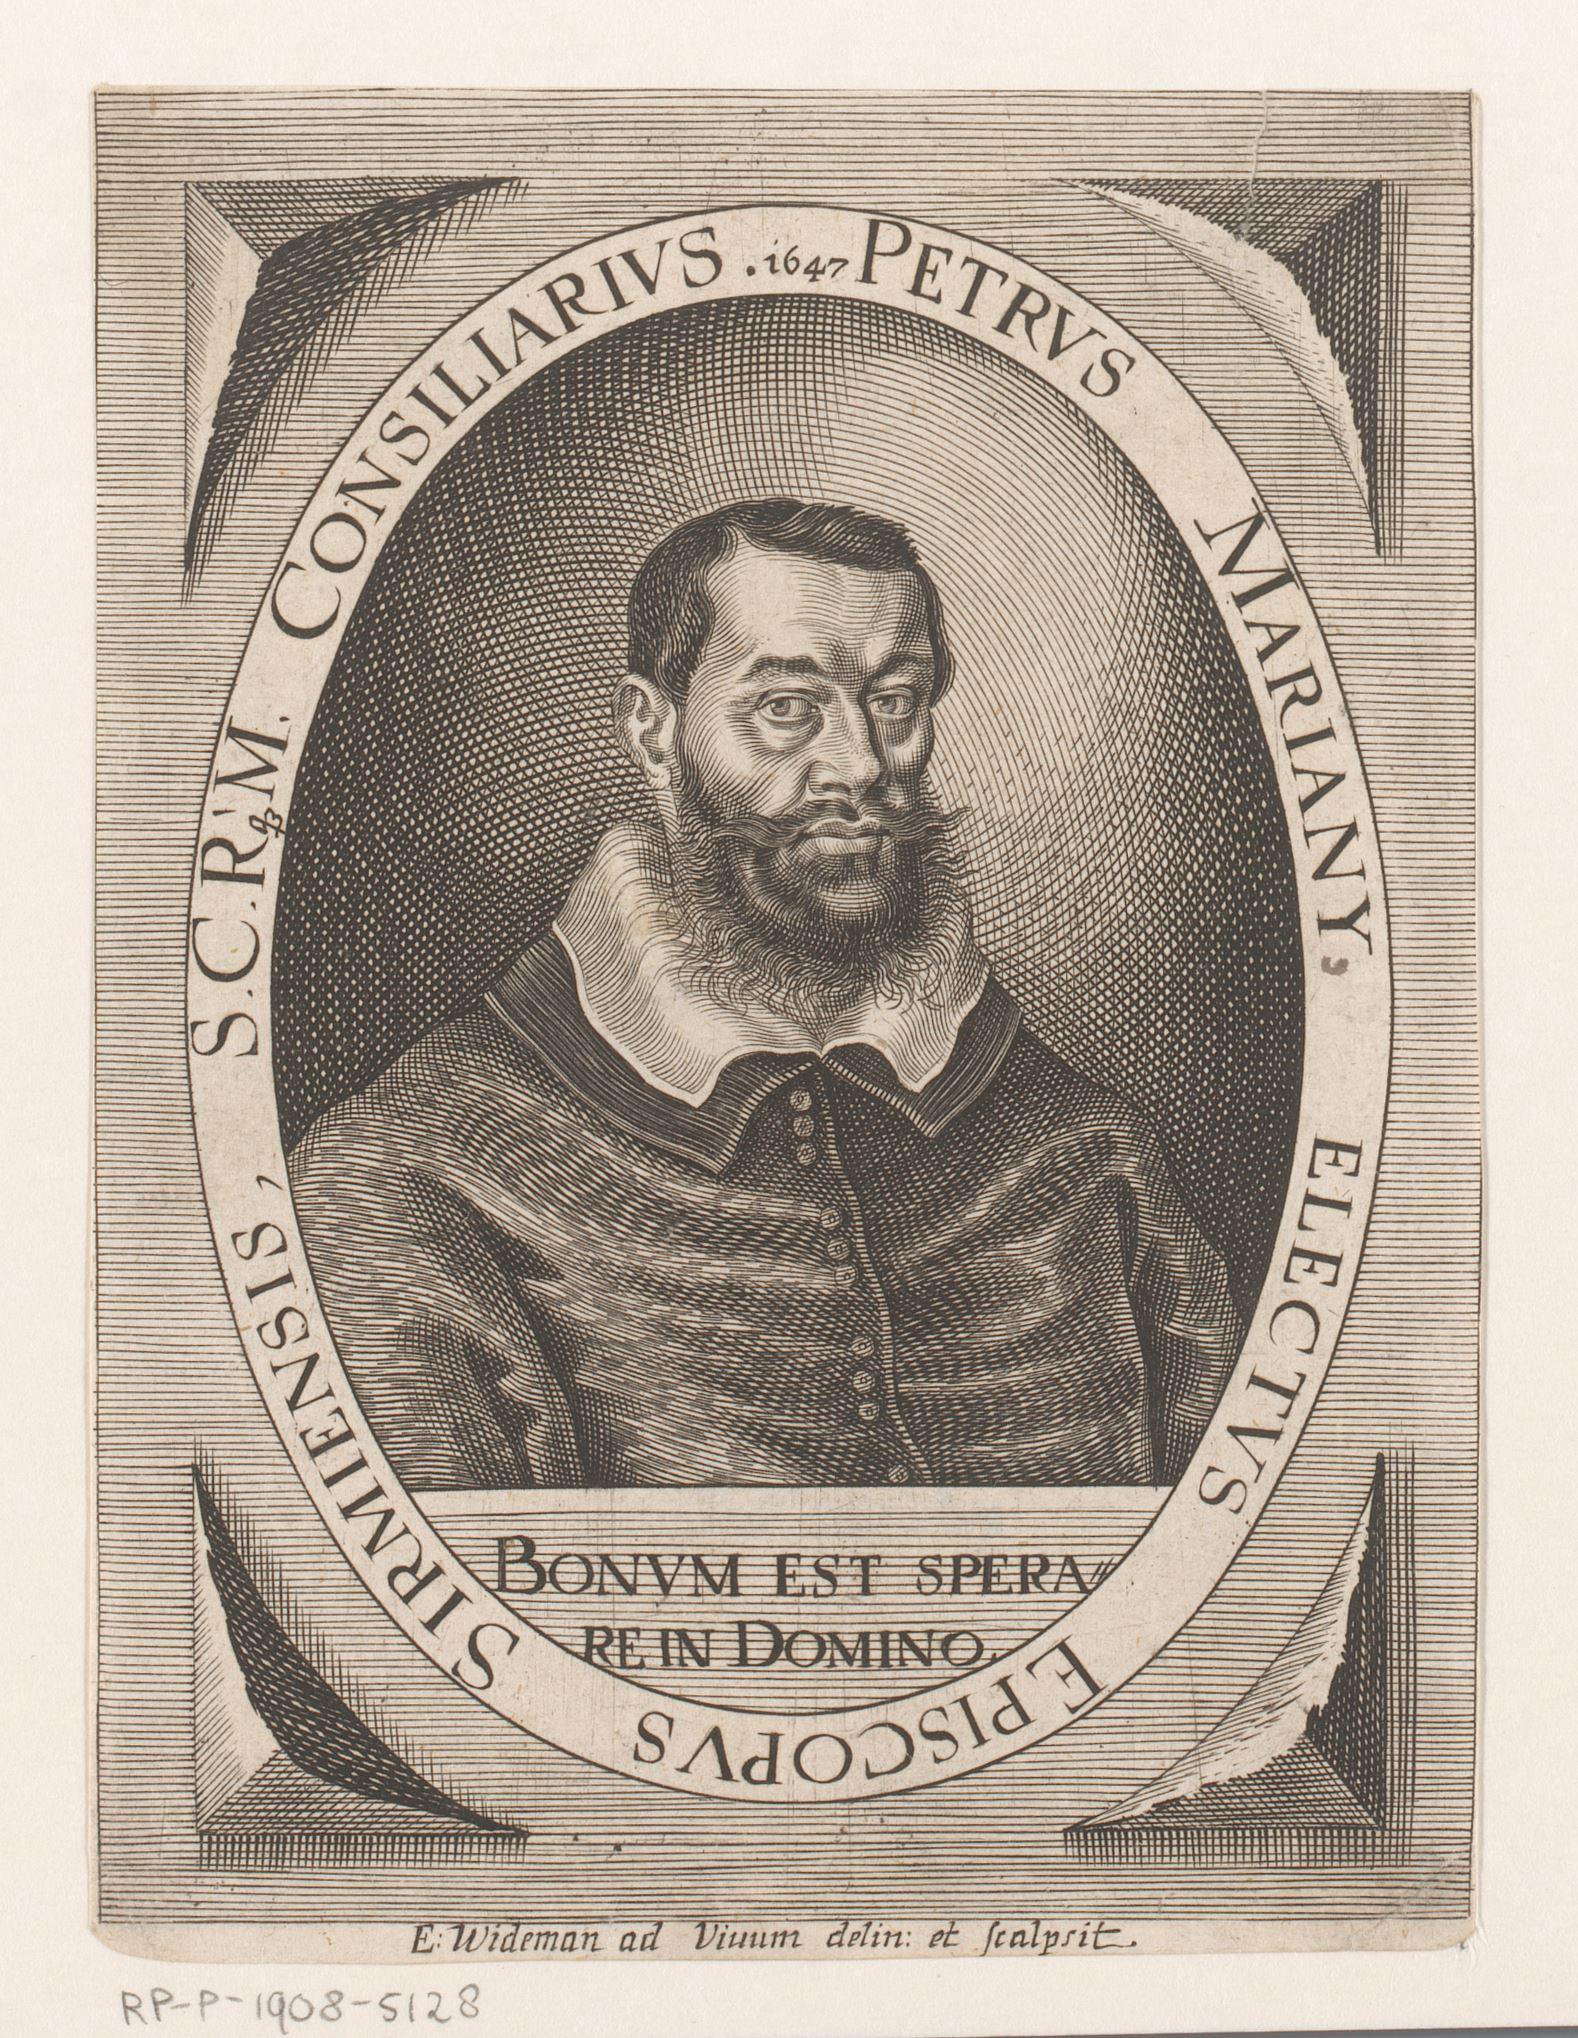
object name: print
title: Portret van Peter Mariany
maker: elias widemann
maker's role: print maker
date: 1647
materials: paper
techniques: engraving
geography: vienna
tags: historical persons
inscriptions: collector's mark: Lugt 2228